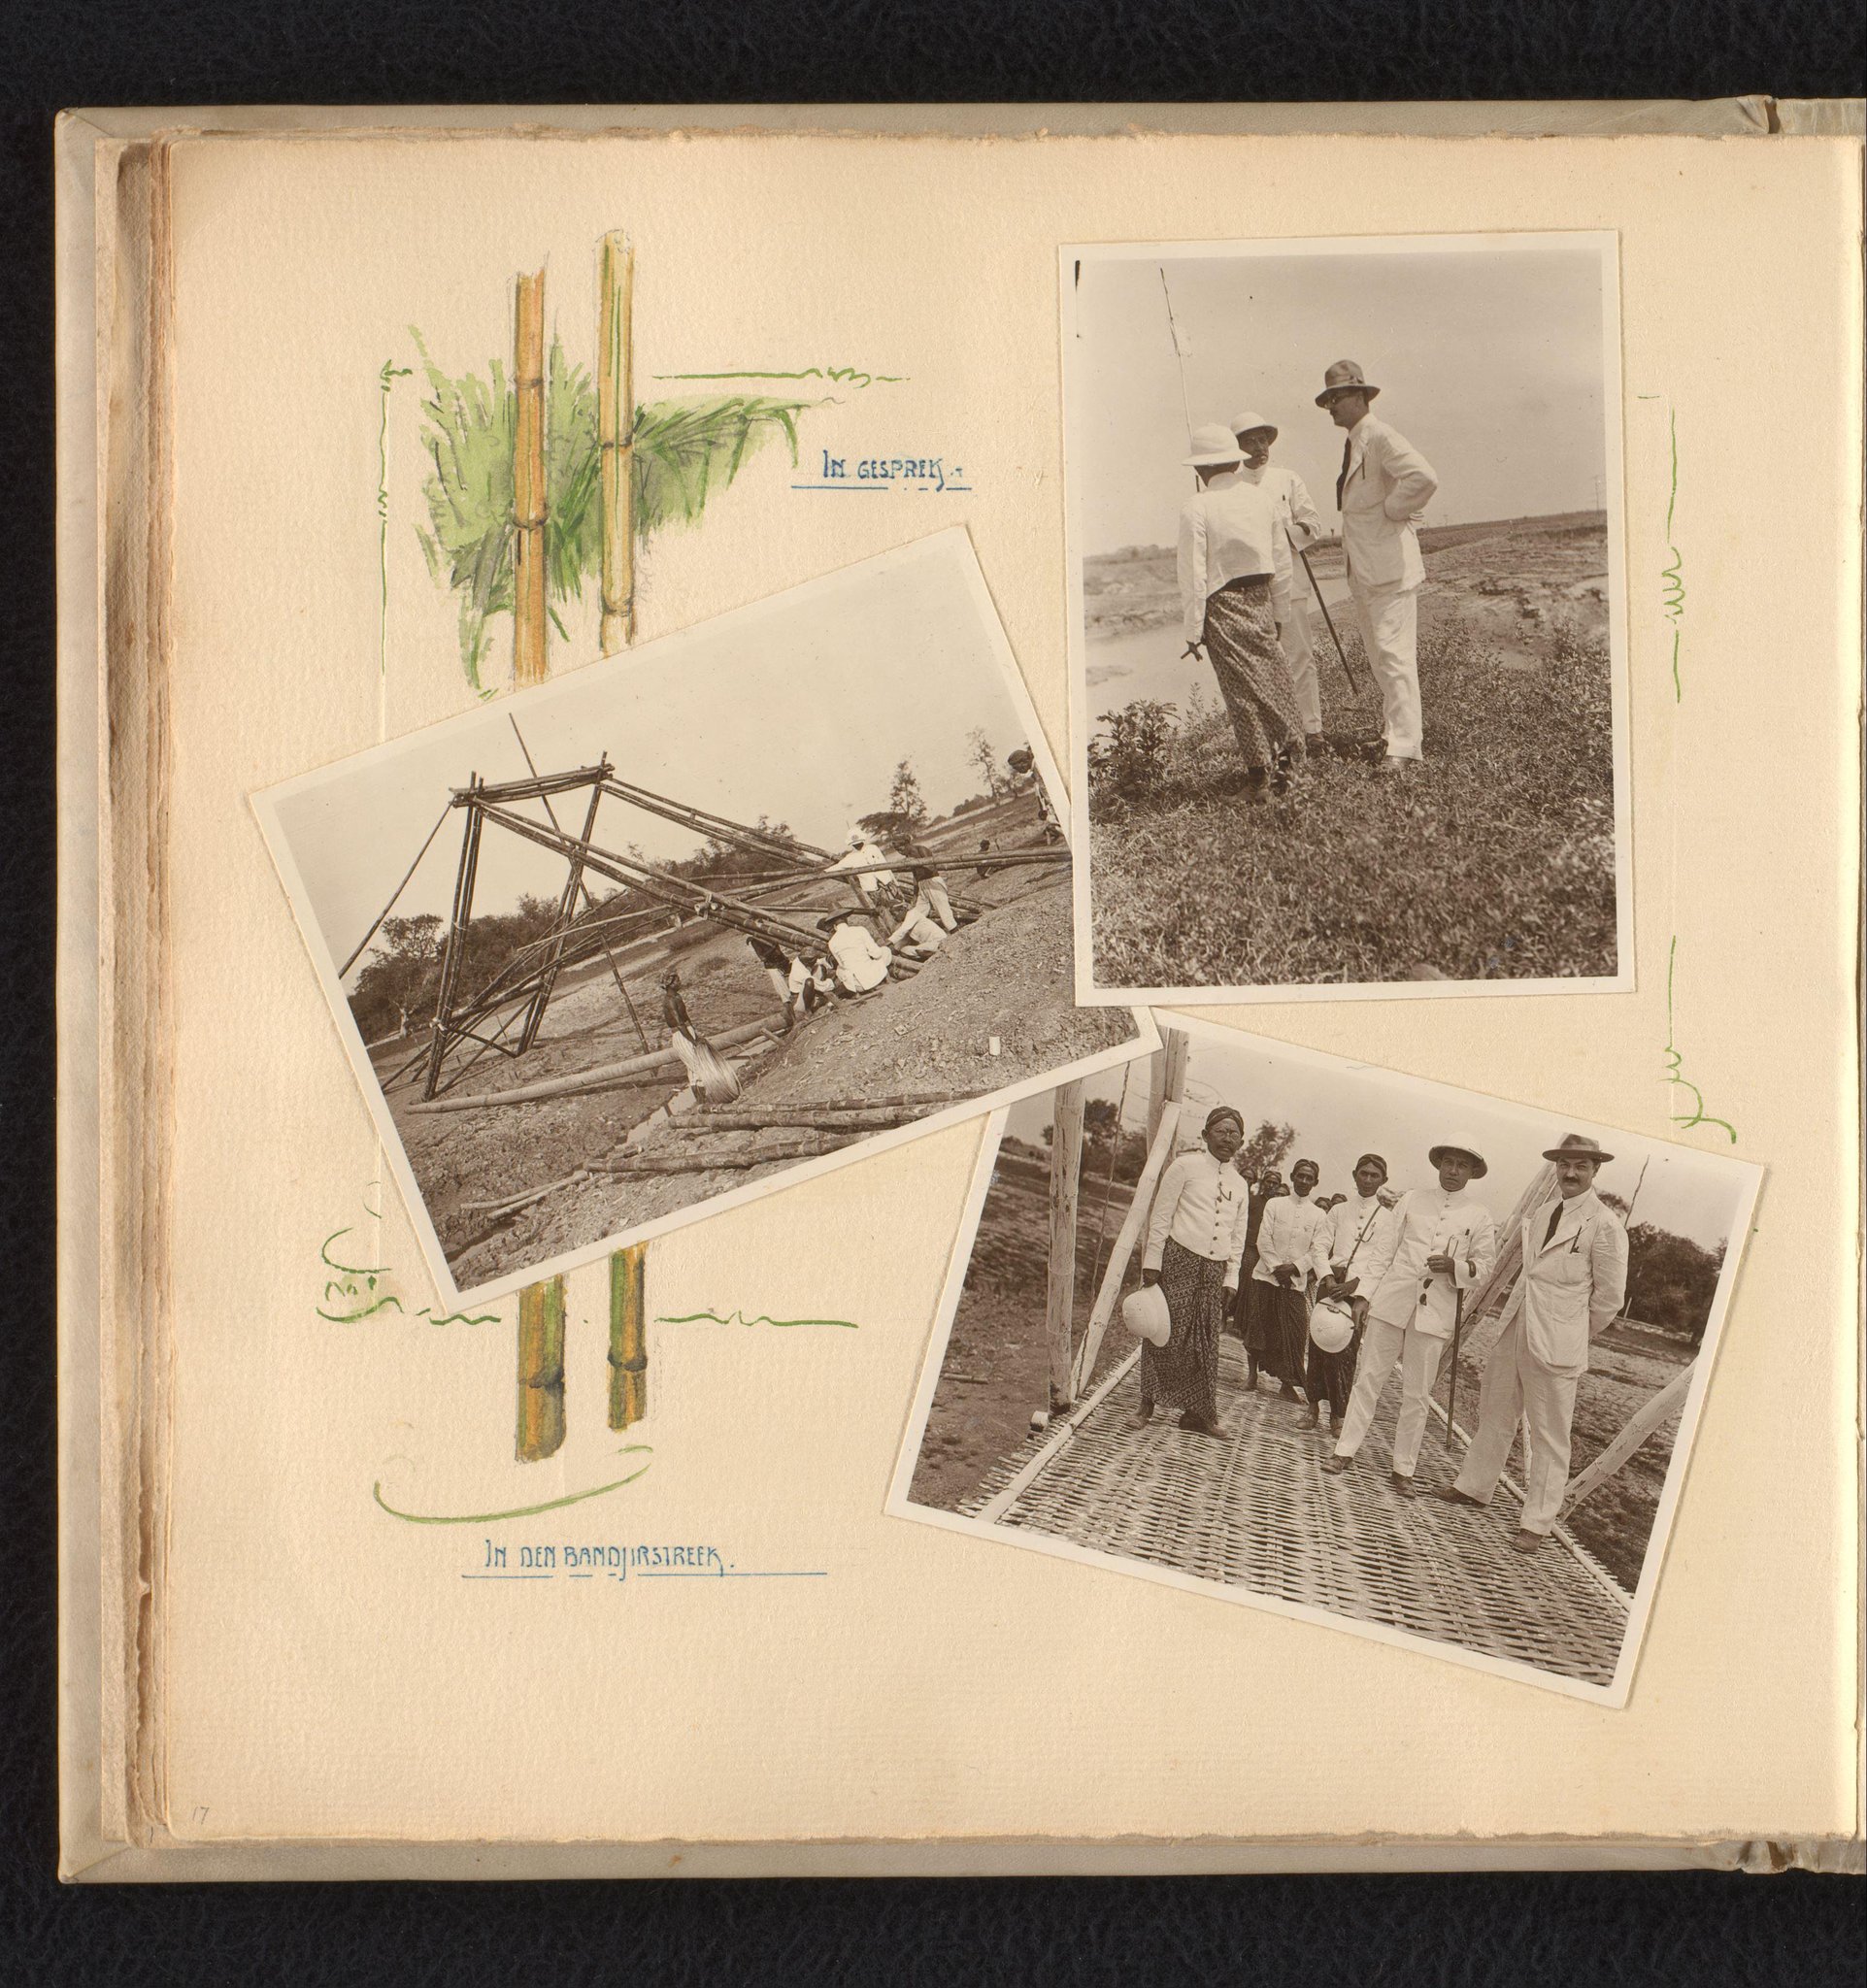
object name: photograph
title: Habbema op werkbezoek in Banjir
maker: Anonymous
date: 1910-1928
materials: paper, photographic support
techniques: drawing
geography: grobogan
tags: provincial government, colonial government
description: Albumblad met drie foto's van Habbema op werkbezoek in de Banjir (Bandjirstreek) in Grobogan. Het blad is versierd met bamboe en randwerk om de foto's. Onderdeel van het fotoalbum aangeboden aan J. Habbema door het Binnenlandsch Bestuur Corps van het Regentschap Grobogan, bij het beëindigen van zijn bestuur over het Regentschap, waarschijnlijk in 1928.